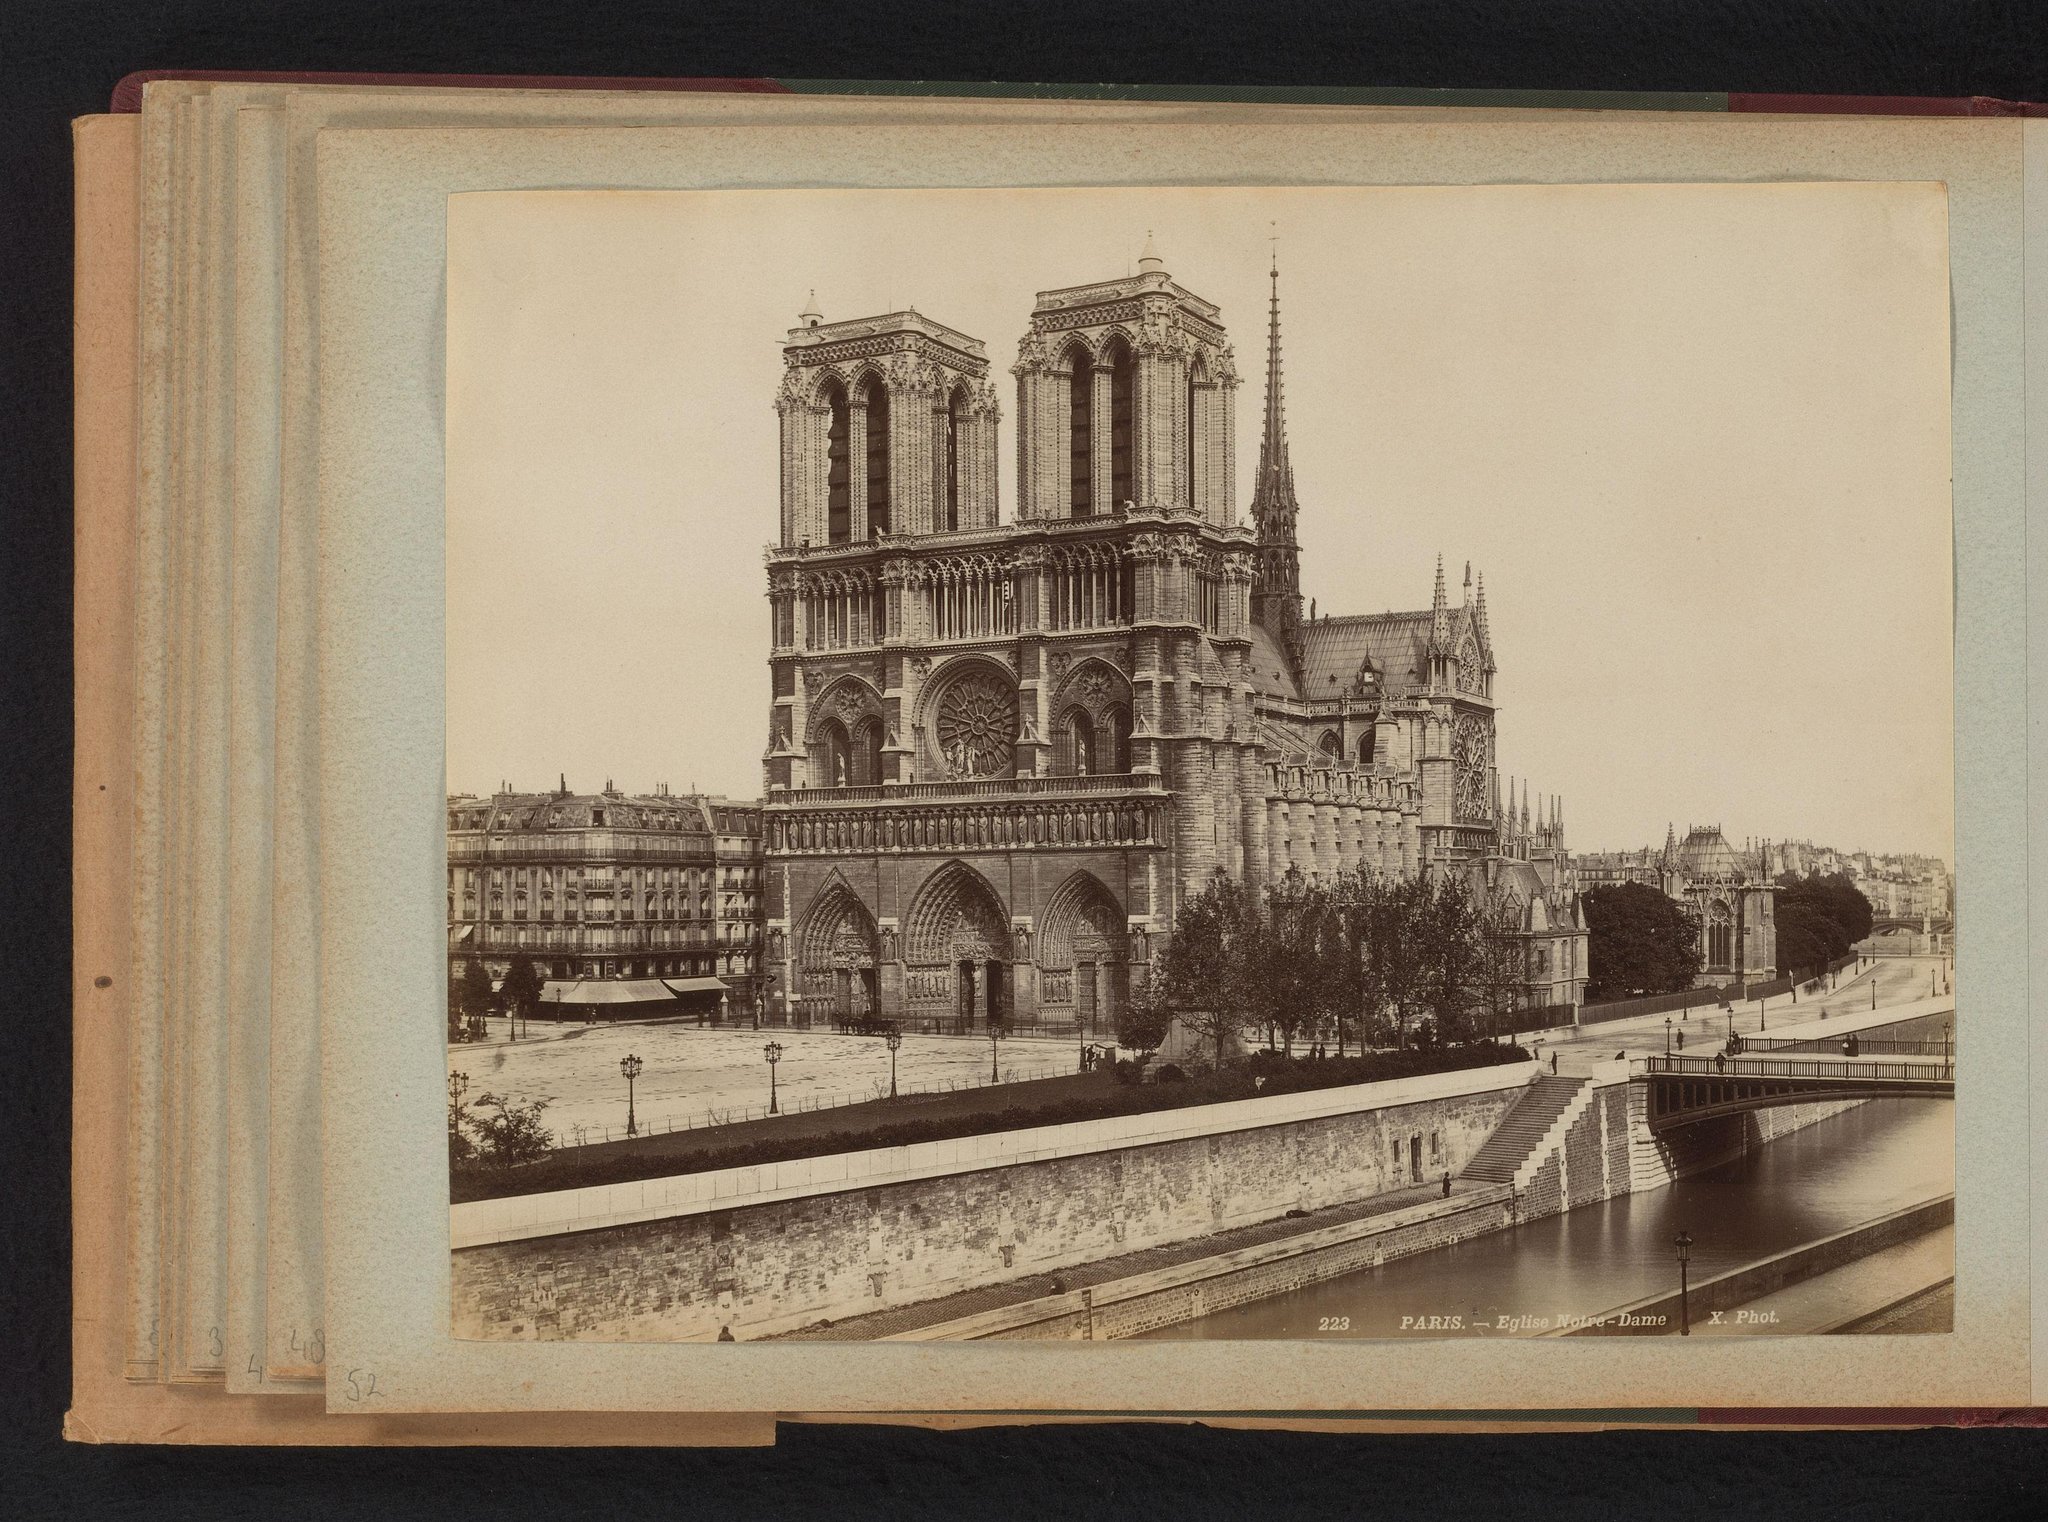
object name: album leaf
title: Gezicht op de Notre Dame in Parijs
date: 1887-1900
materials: paper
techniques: albumen print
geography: paris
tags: church (exterior)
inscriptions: number: ‘223.’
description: Tussen 1887 en ca. 1900 werkten Neurdein frères onder andere onder de naam 'X phot.'.